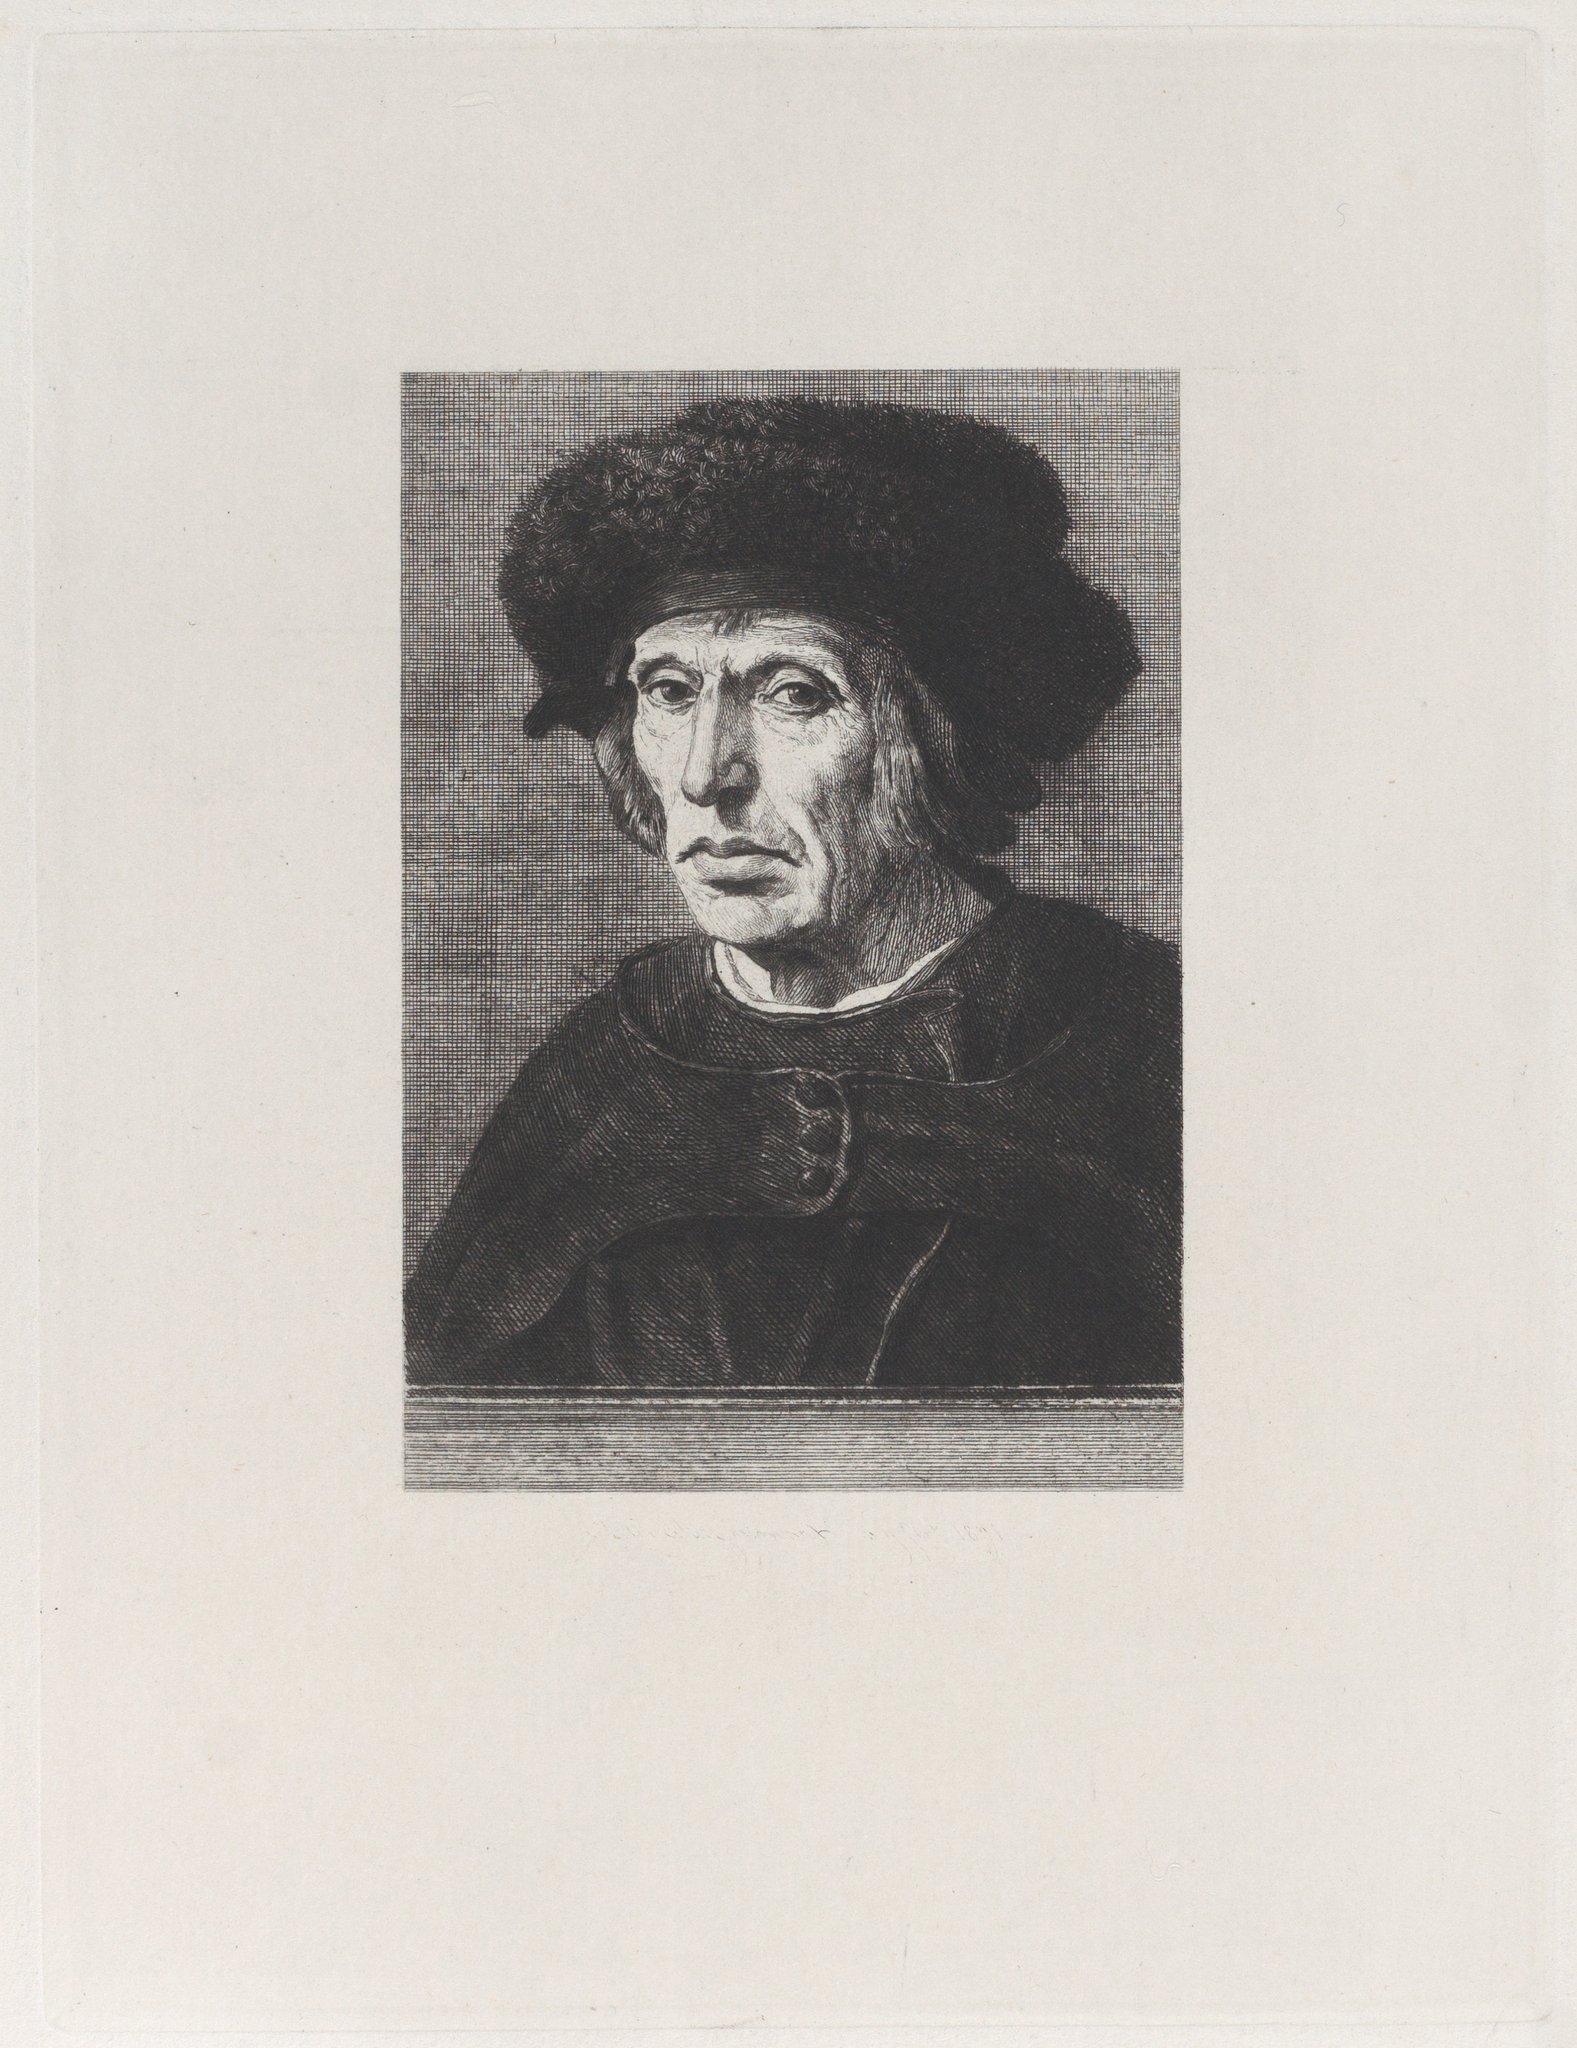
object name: print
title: Portrait of Jacob van Veen, after Maarten van Heemskerck, from "Etchings of Pictures in the Metropolitan Museum New York"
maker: jules-ferdinand jacquemart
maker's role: artist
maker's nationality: french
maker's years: 1837-1880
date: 1871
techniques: etching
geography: london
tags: men,portraits